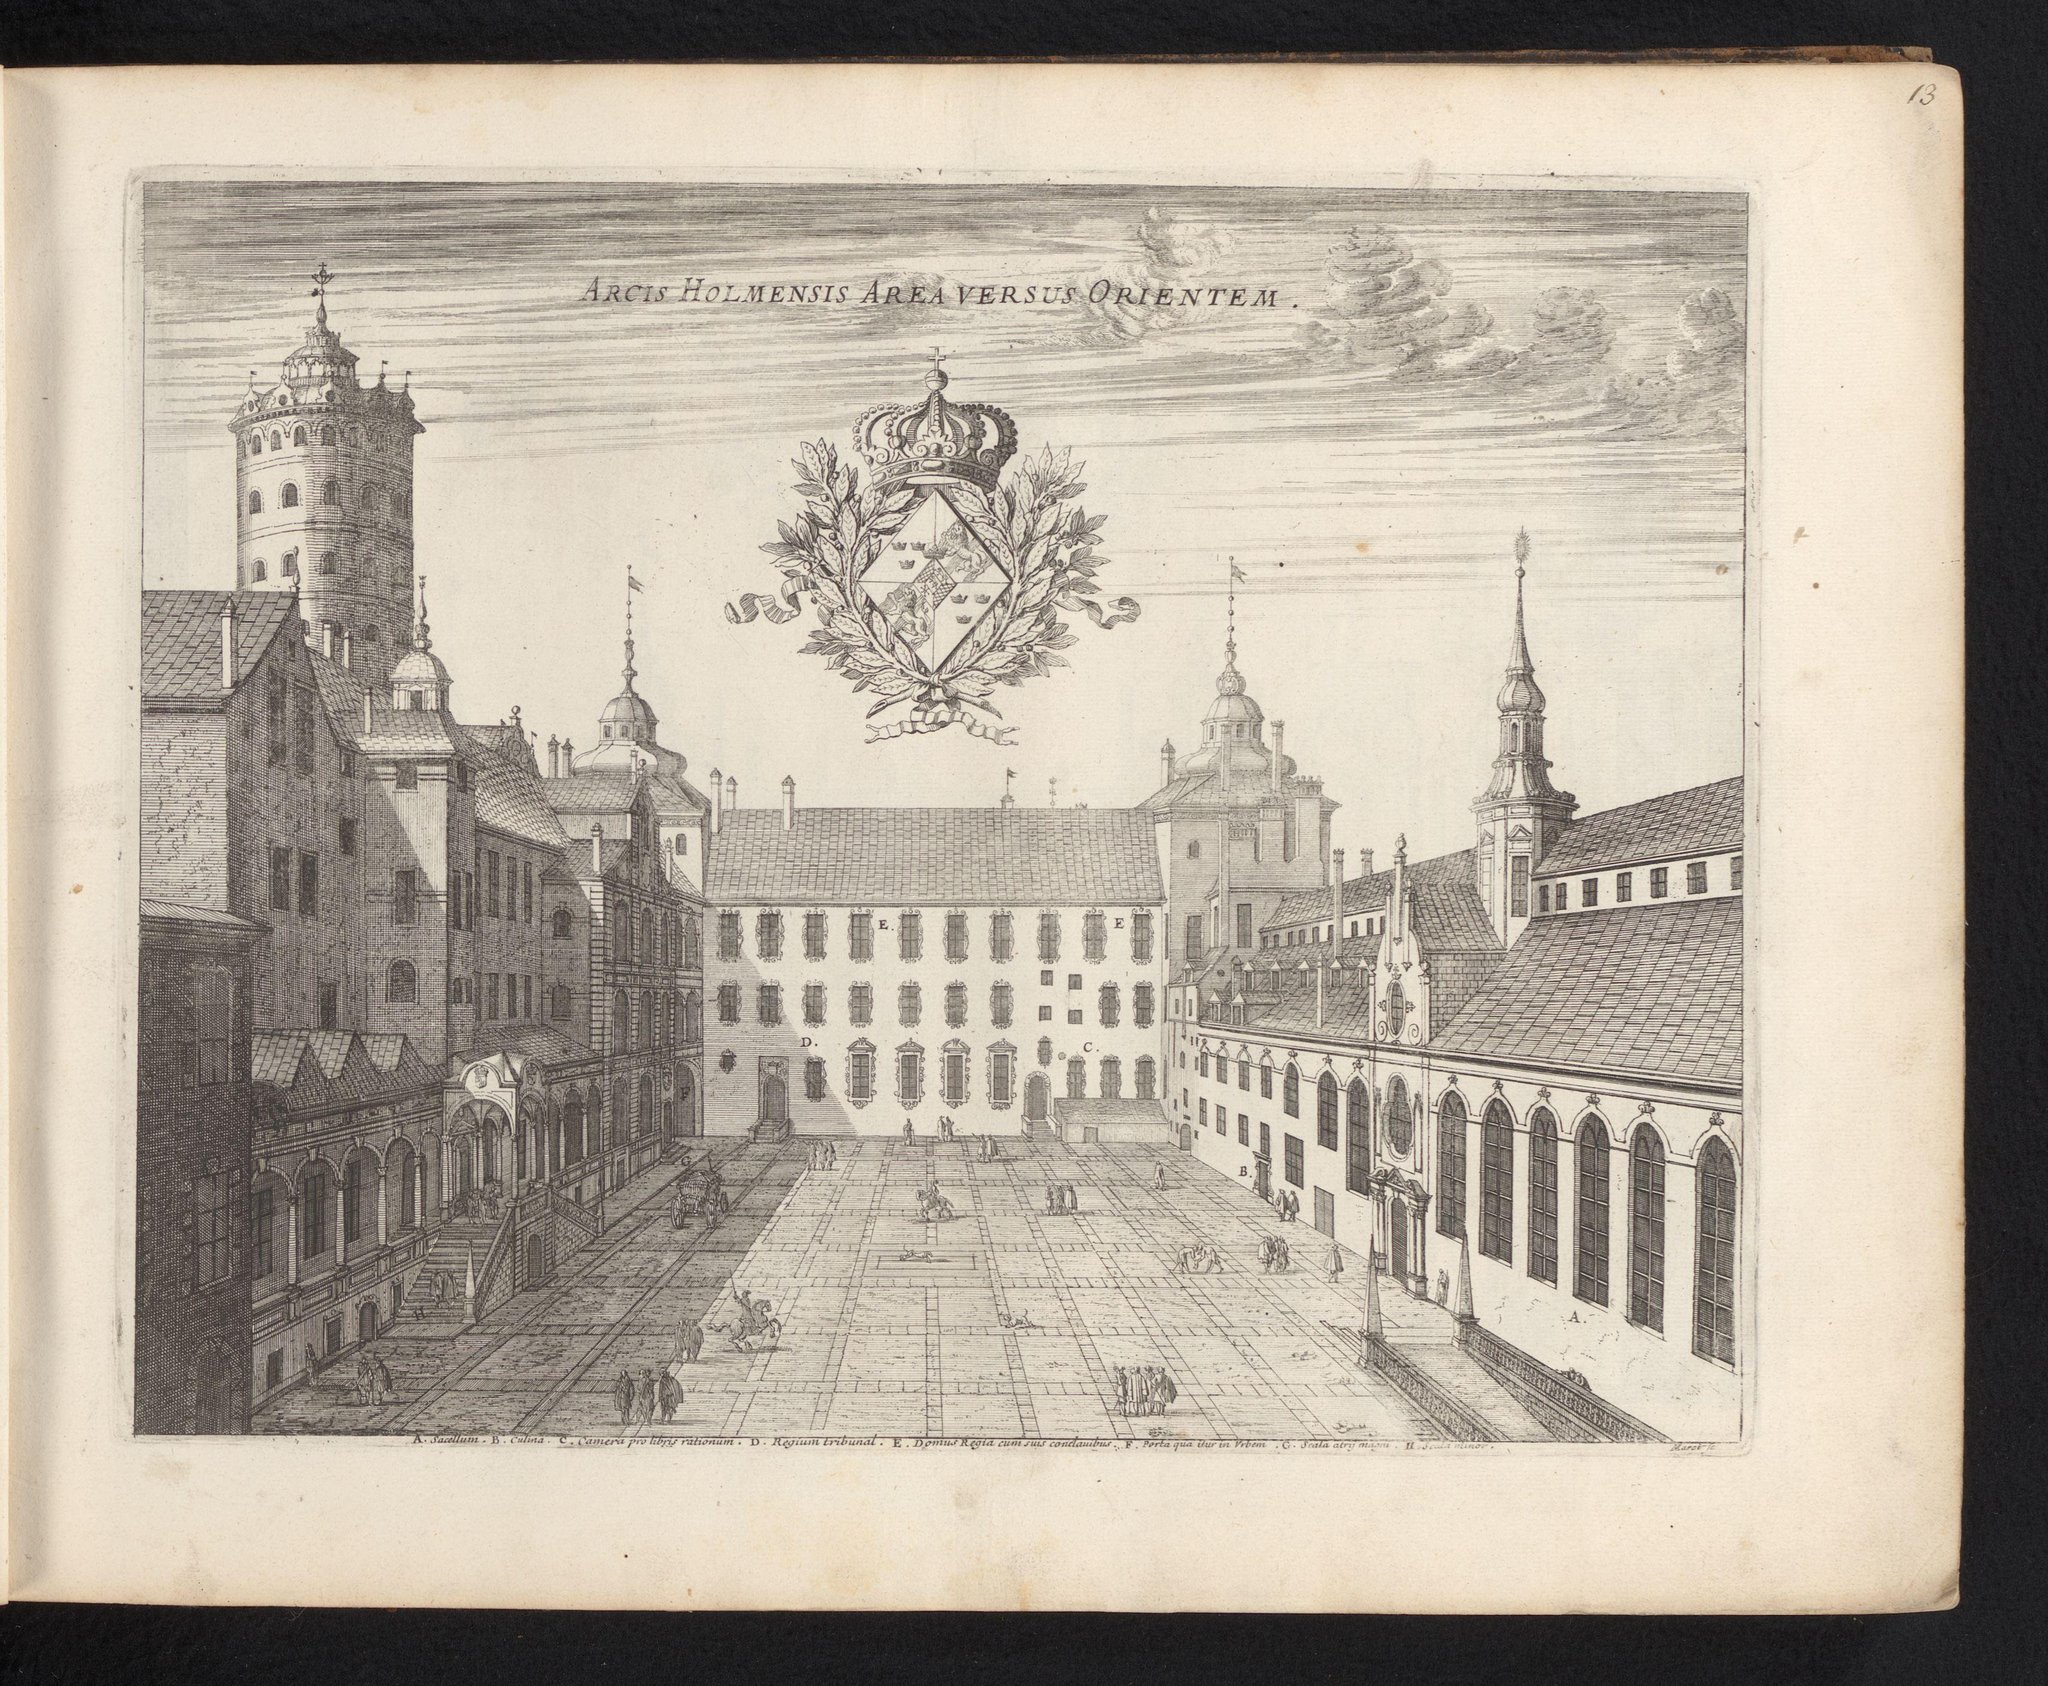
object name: print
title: Suecia Antiqua et Hodierna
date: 1670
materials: paper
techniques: etching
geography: france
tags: castle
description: Kungliga Biblioteket, 'Suecia': http://www.kb.se/samlingarna/Kartor-bilder/Suecia-antiqua/ (geraadpleegd november 2016).